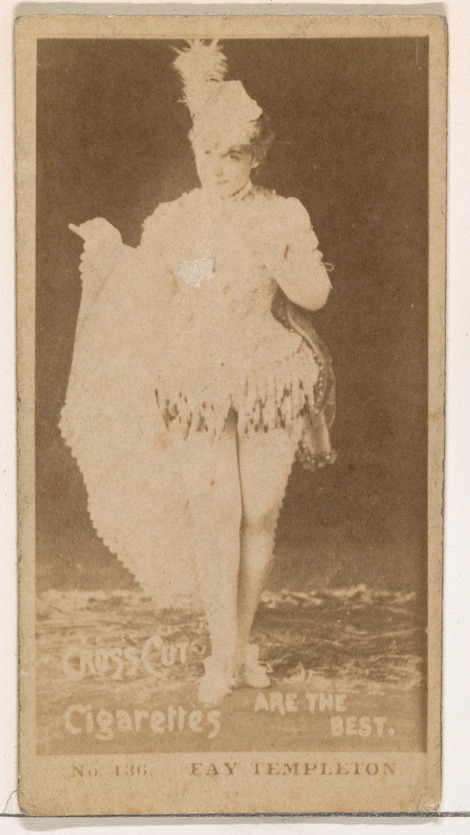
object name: print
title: Card Number 136, Fay Templeton, from the Actors and Actresses series (N145-2) issued by Duke Sons & Co. to promote Cross Cut Cigarettes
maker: w. duke, sons & co.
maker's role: publisher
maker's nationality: american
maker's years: 1870-1920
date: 1880-1889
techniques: albumen silver print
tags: portraits,women,actresses